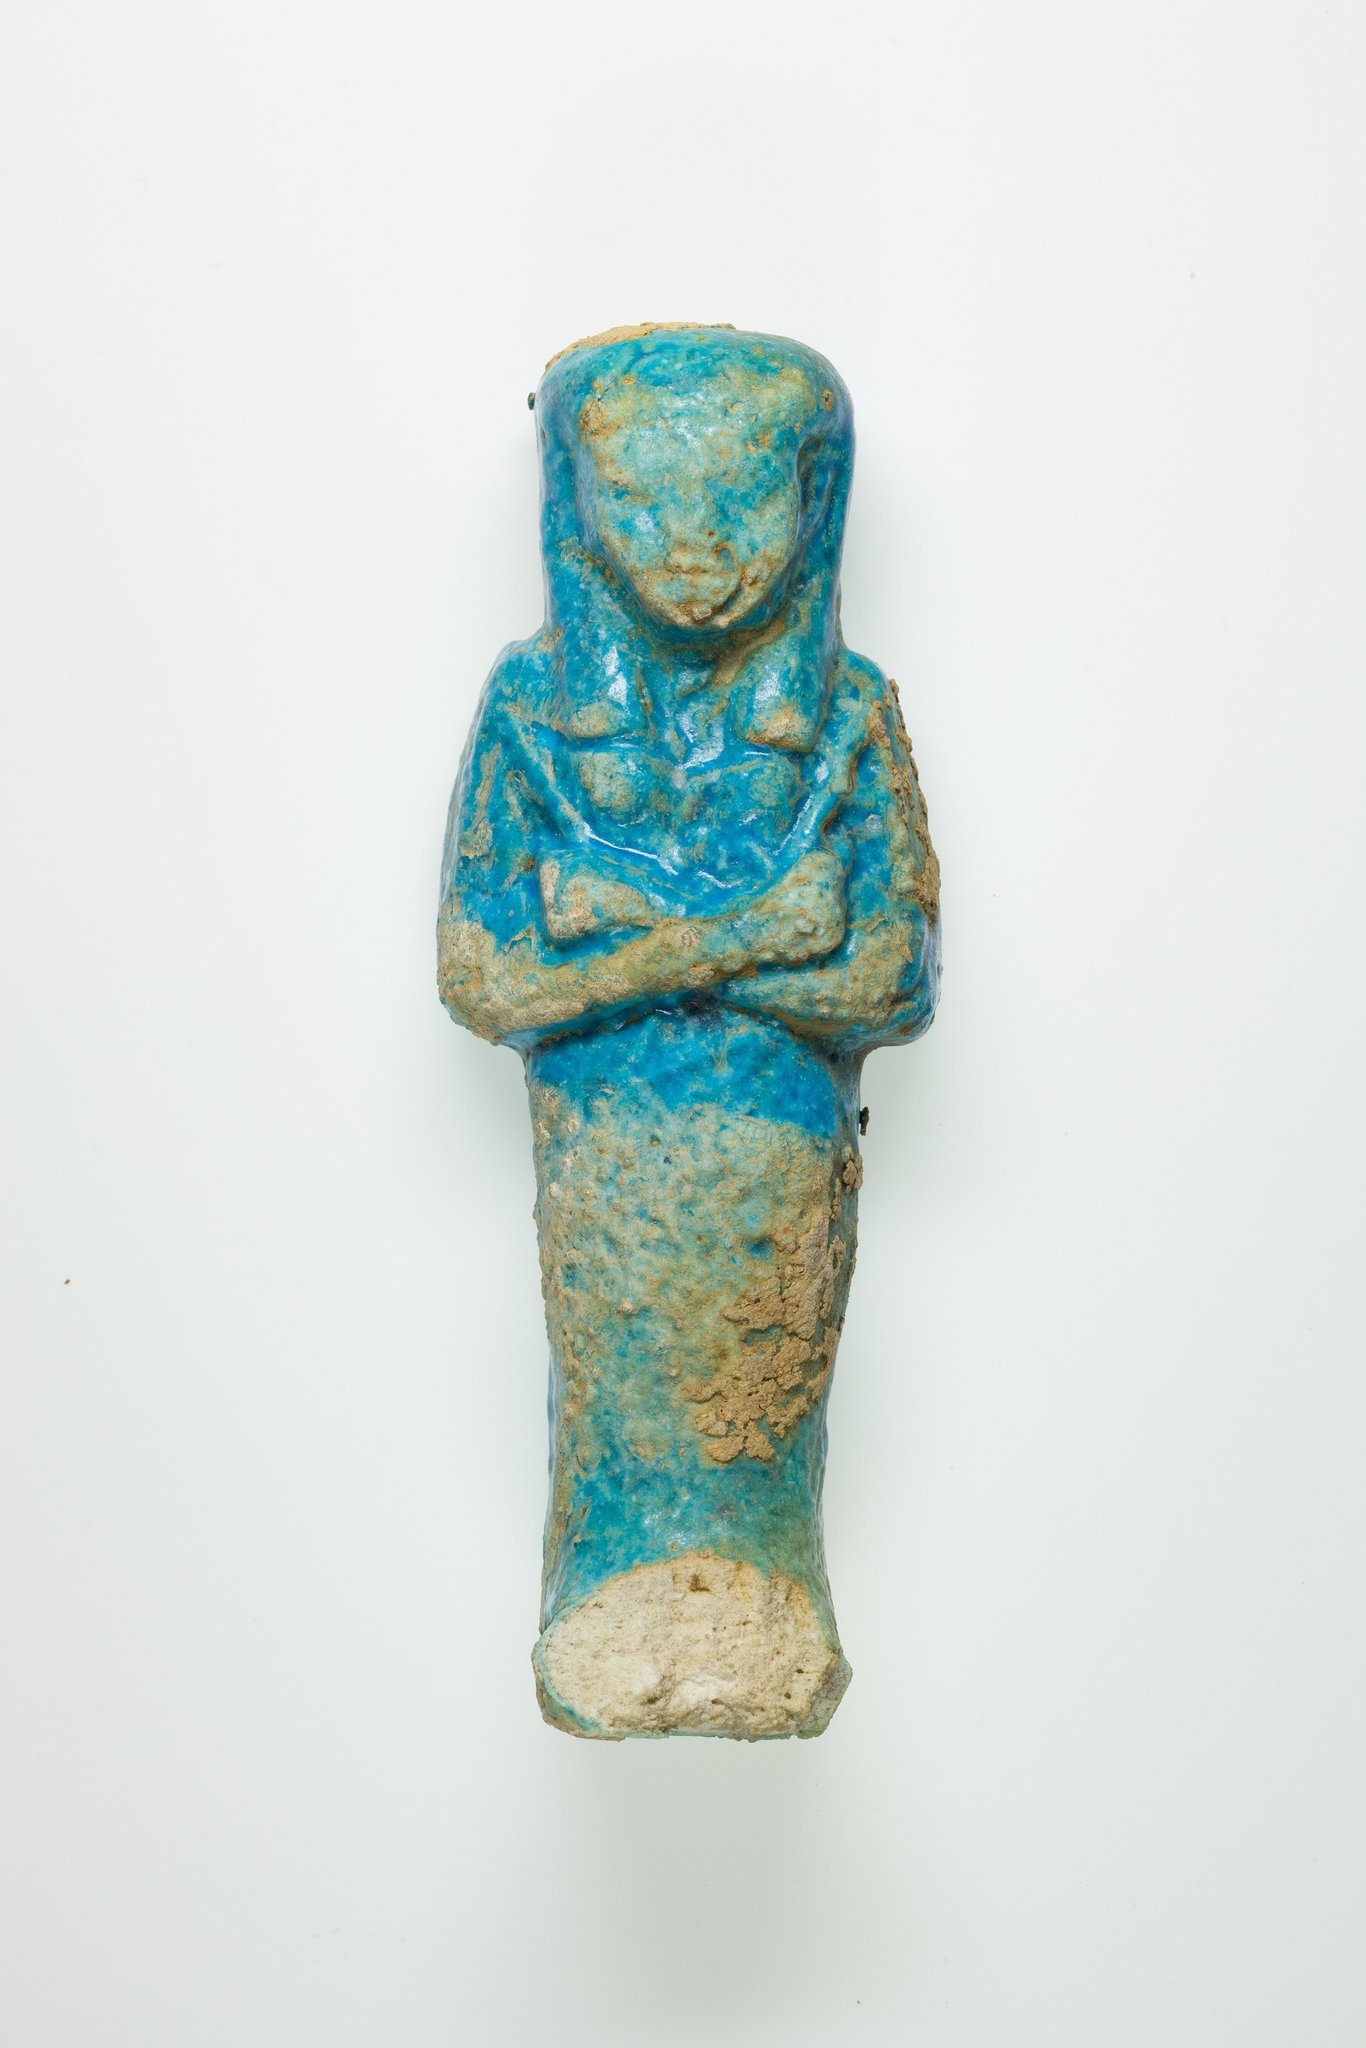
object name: worker shabti, henettawy c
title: Worker Shabti of Henettawy (C), Daughter of Isetemkheb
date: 990-970 BCE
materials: faience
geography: egypt